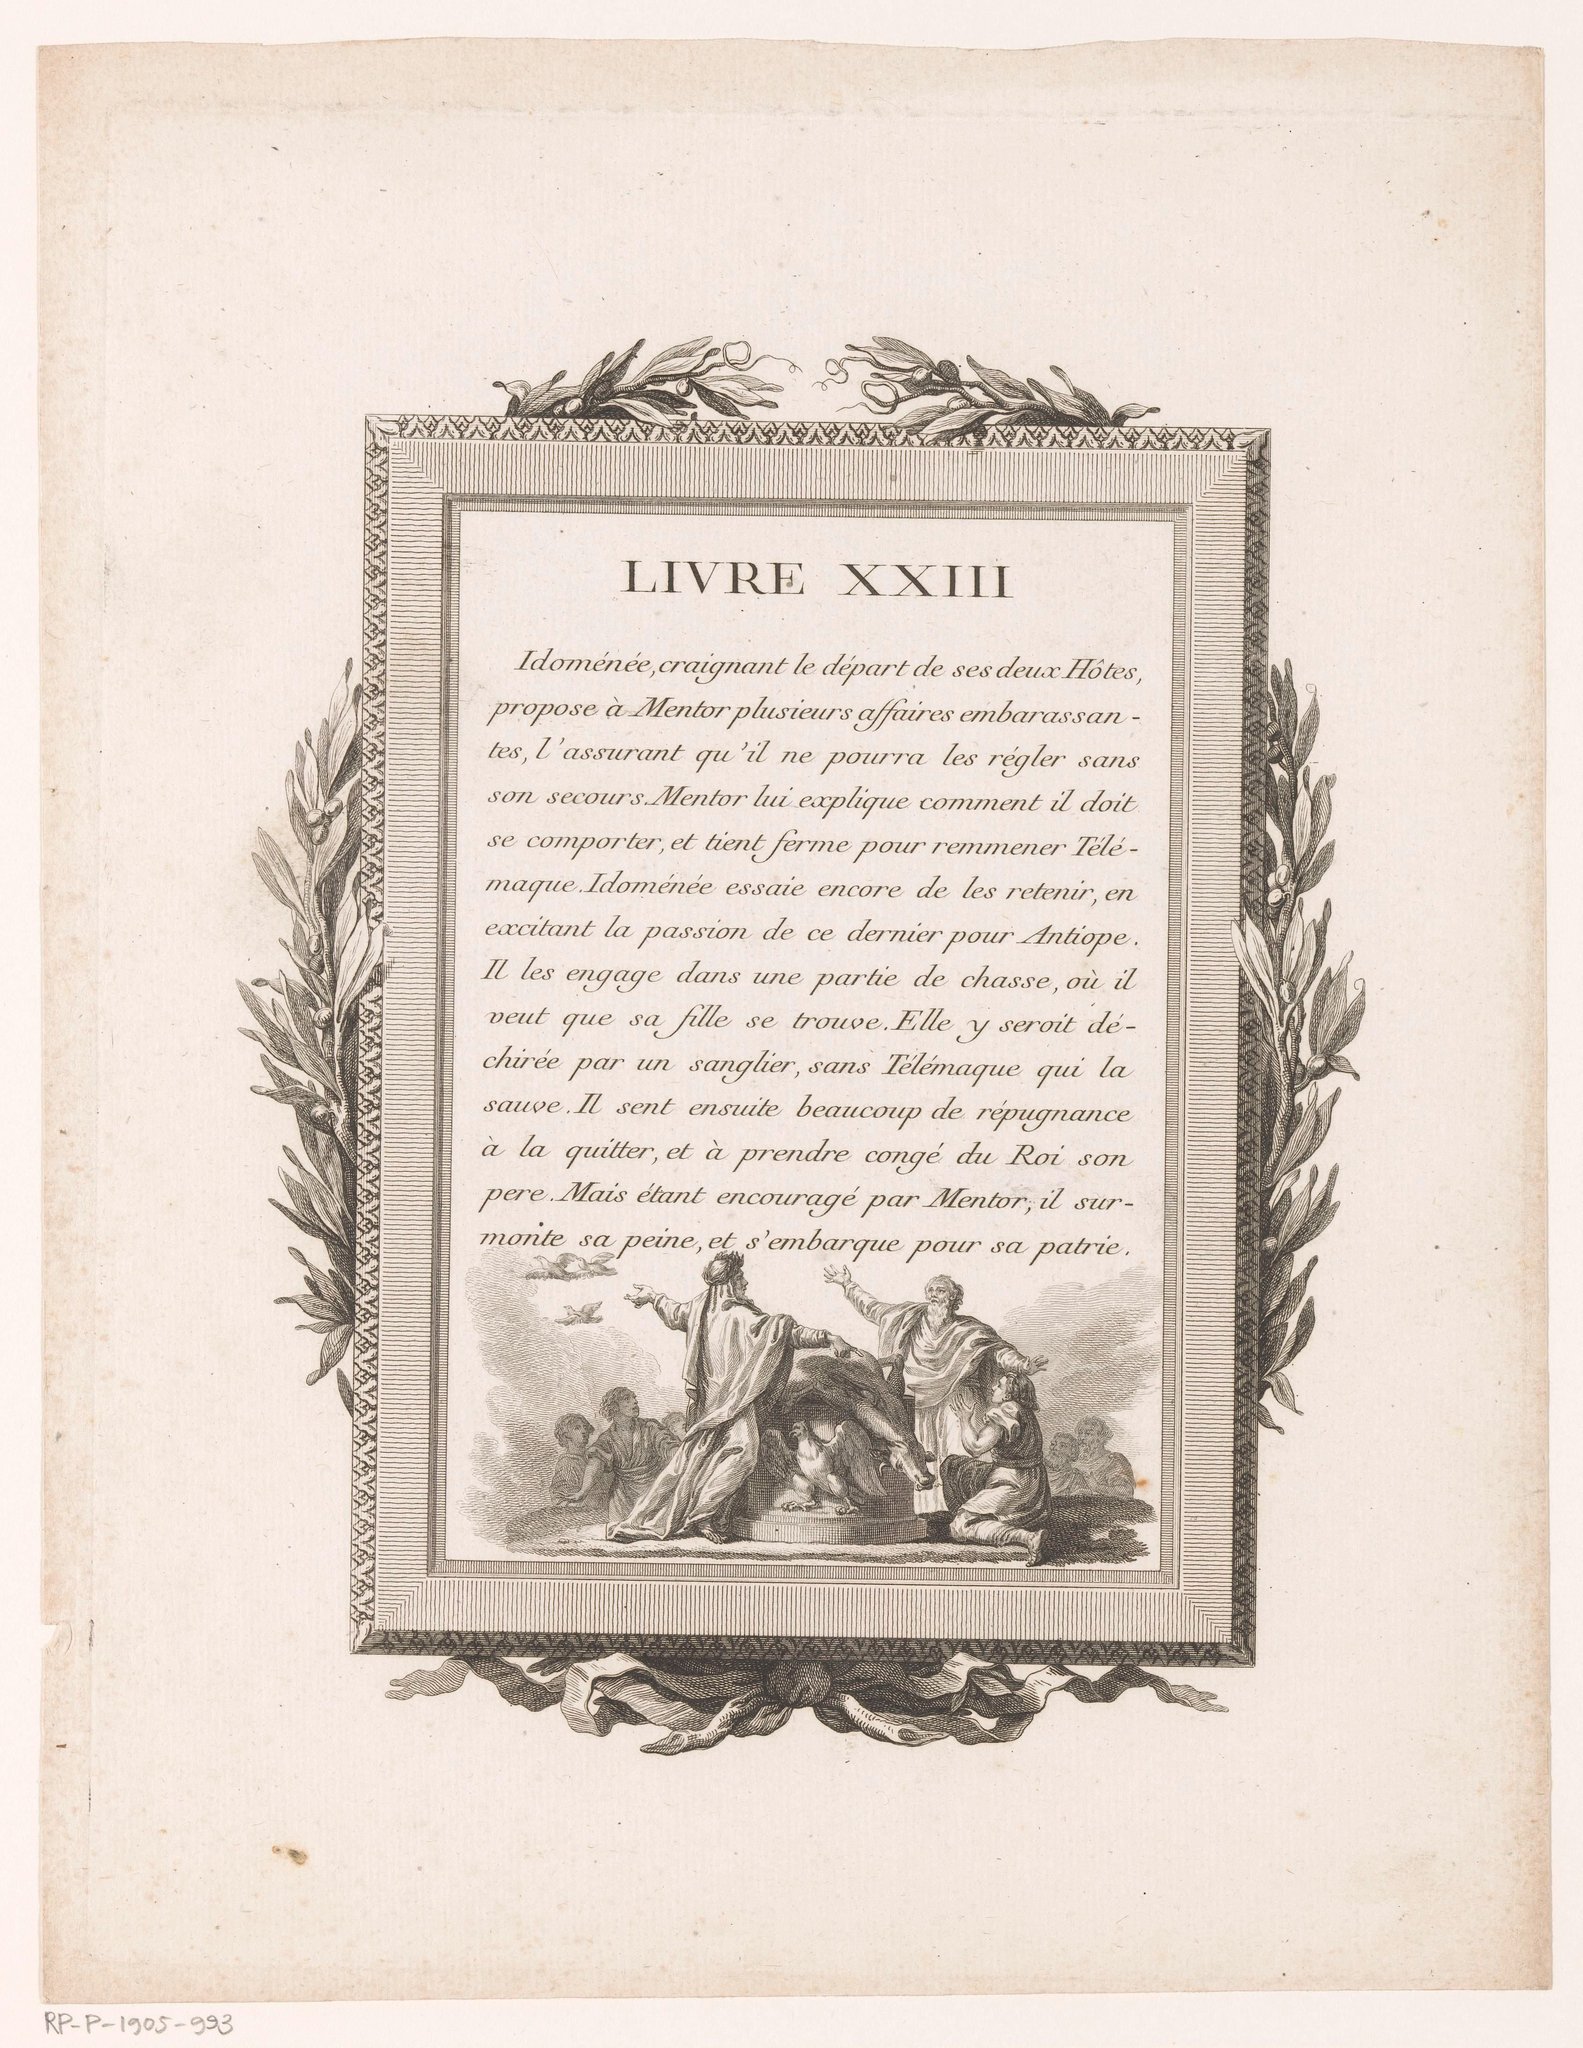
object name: book illustration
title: Omkaderde Franse tekst met olijftakken en een groep offerende figuren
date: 1785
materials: paper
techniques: engraving, etching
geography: paris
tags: (fenelon, telemachus) specific works of literature (with author, title), ornament ~ festoon, garland, animal sacrifice ~ non-christian religions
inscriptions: collector's mark: Lugt 2228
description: Veertienregelige Franse tekst, getiteld 'Livre XXIII' met daaronder een afbeelding van een groep figuren rond een altaar voor Jupiter, met daarop een dode koe. Het geheel wordt gekaderd door een sierlijst met olijftakken en onderaan een strik.